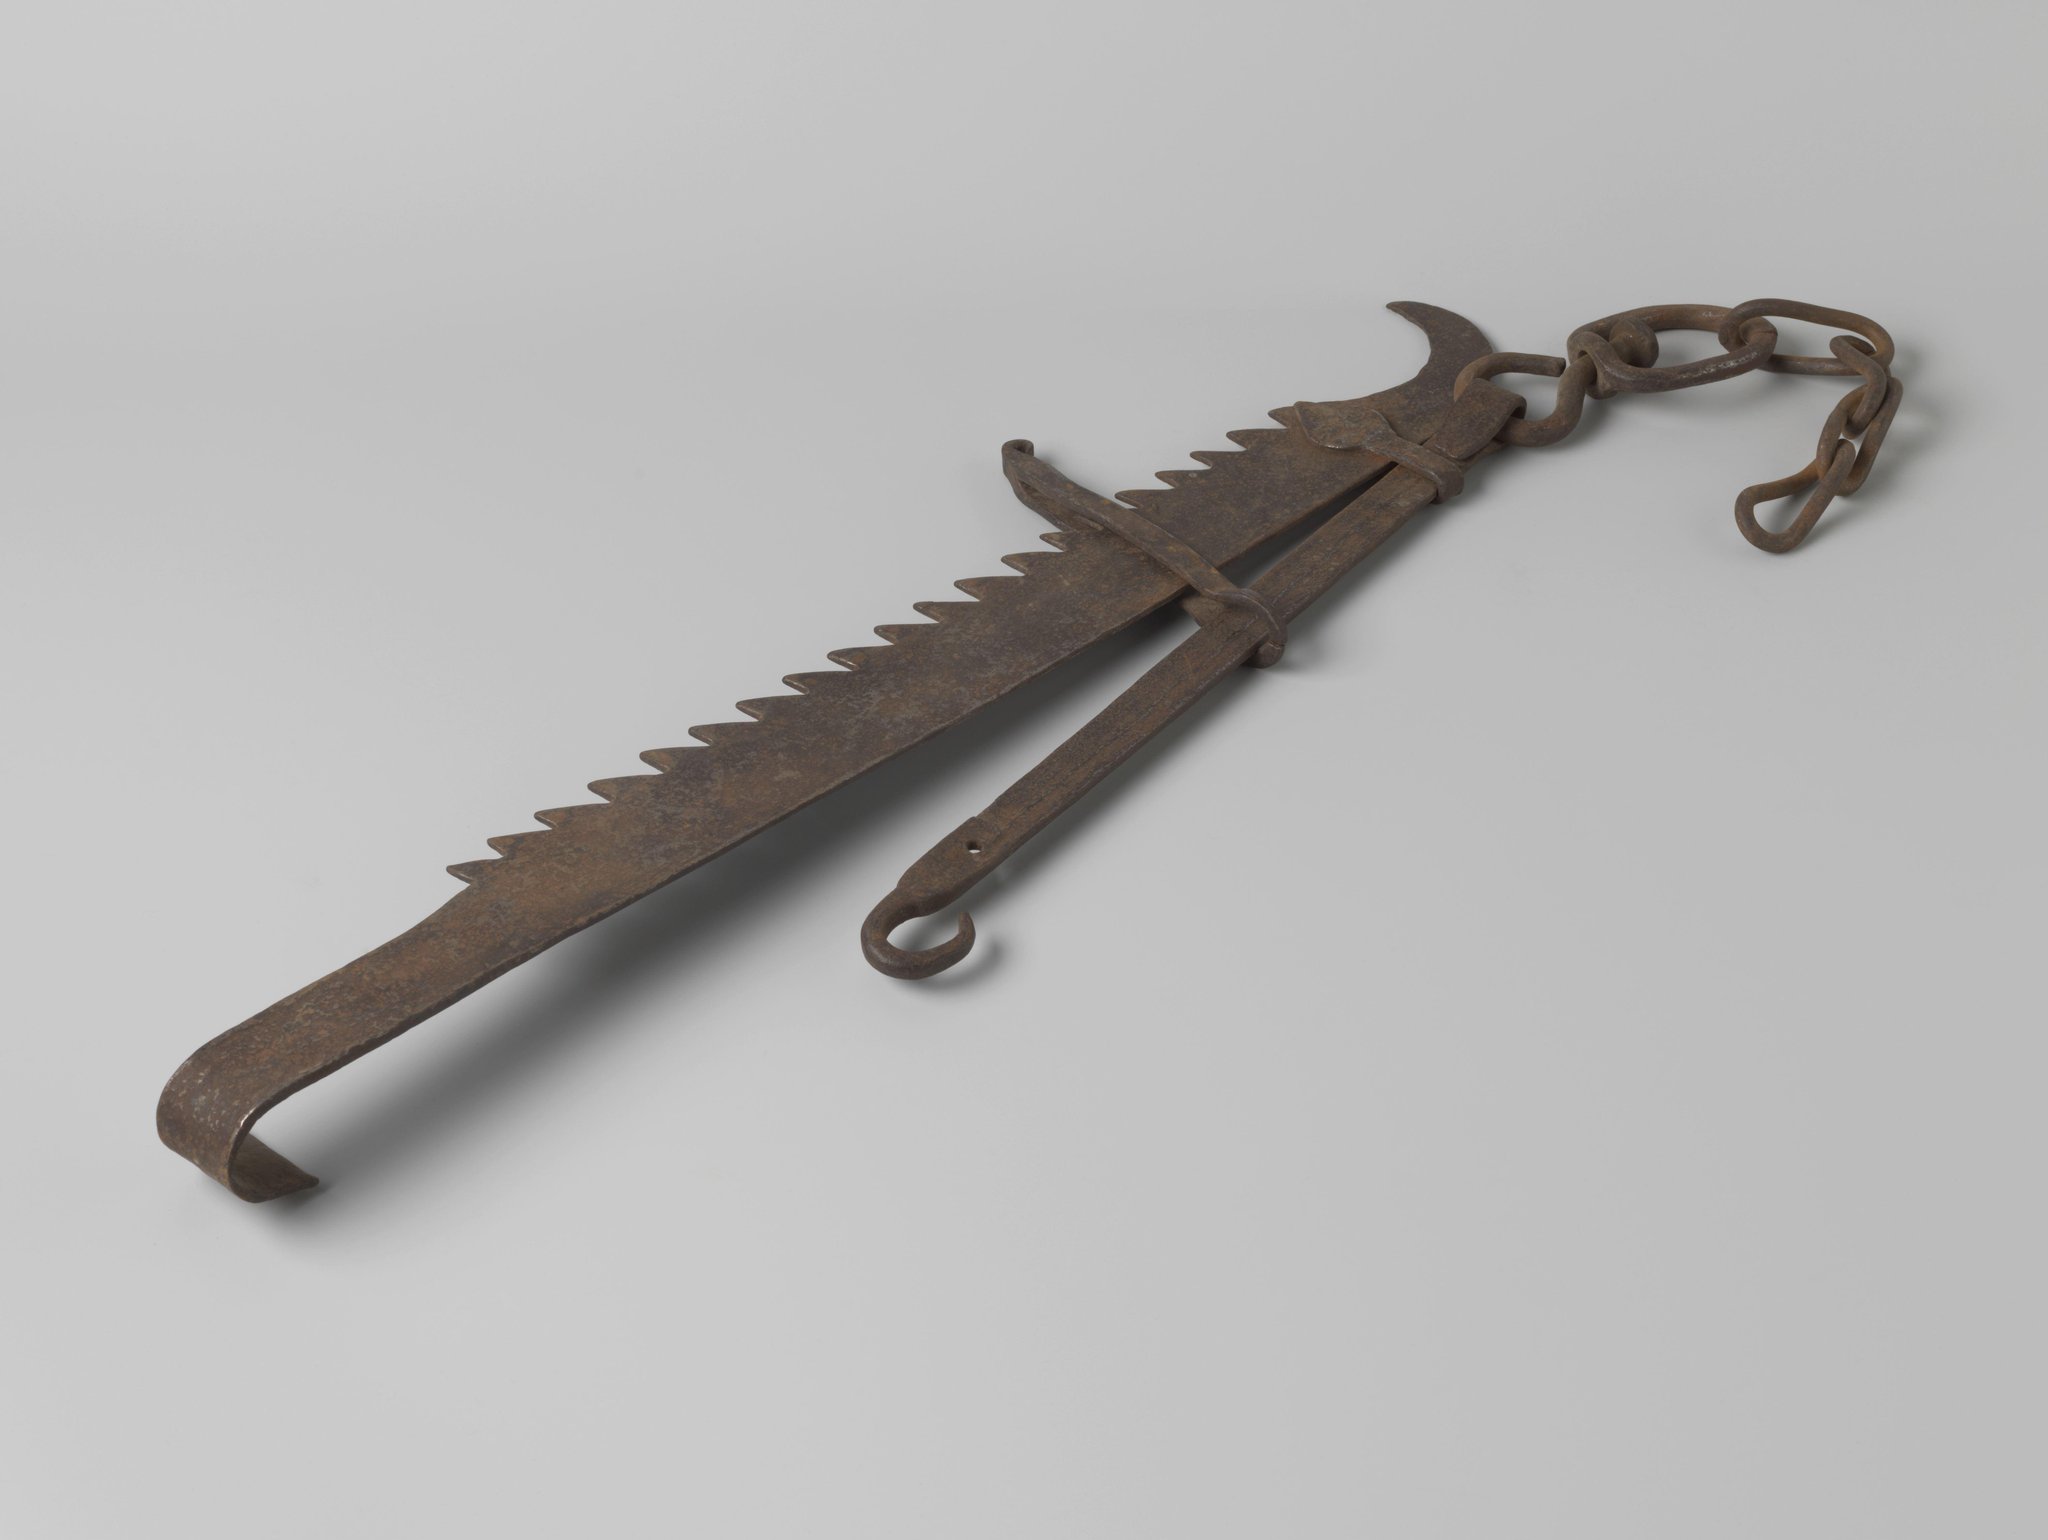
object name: ketelschakel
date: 1400-1950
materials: iron